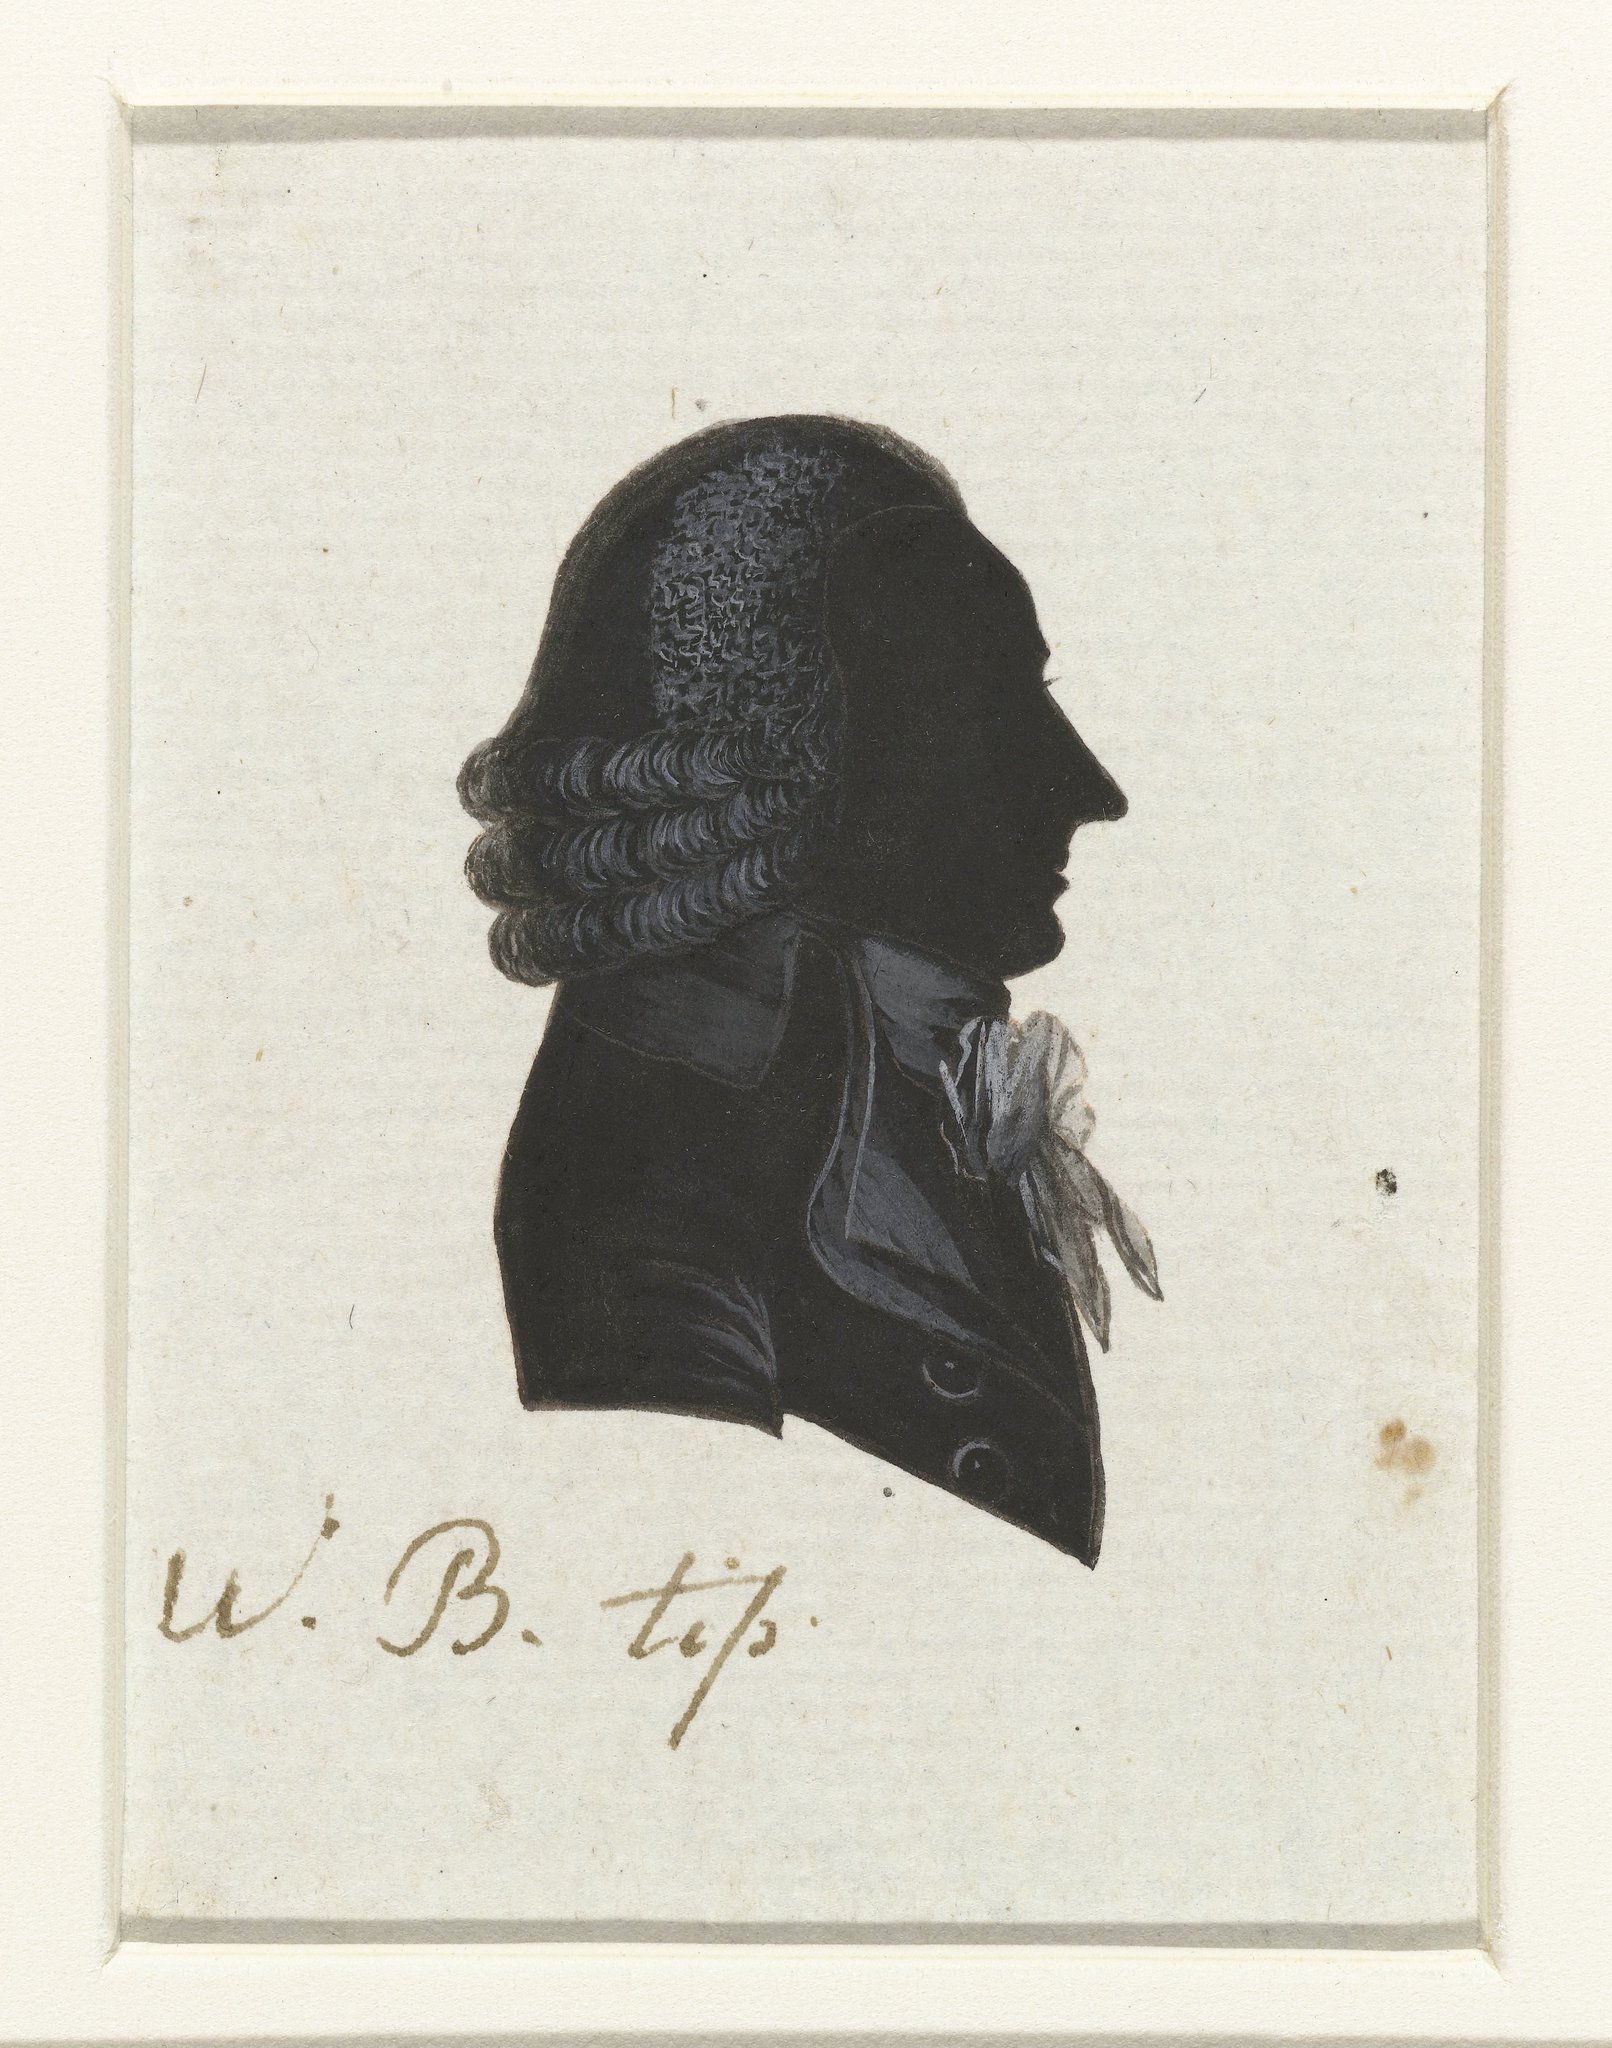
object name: silhouette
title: W.B. Tip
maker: hausdorff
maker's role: draughtsman, print maker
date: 1796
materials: ink, paper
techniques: drawing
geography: netherlands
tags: historical persons (+ profile portrait), the hague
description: Silhouettes of members of the National Assembly. India ink on paper, 1796. Early in 1795 Stadholder William V fled to England. In the Republic a new regime was installed. A year later, the country held its first general election. Every Dutch man over the age of twenty and not on poor relief was entitled to vote for a candidate to the National Assembly, the parliament of the Batavian Republic, as the country was known between 1795 and 1806. The 126 representatives who sat in the assembly were drawn from the educated, progressive elite of Dutch society.